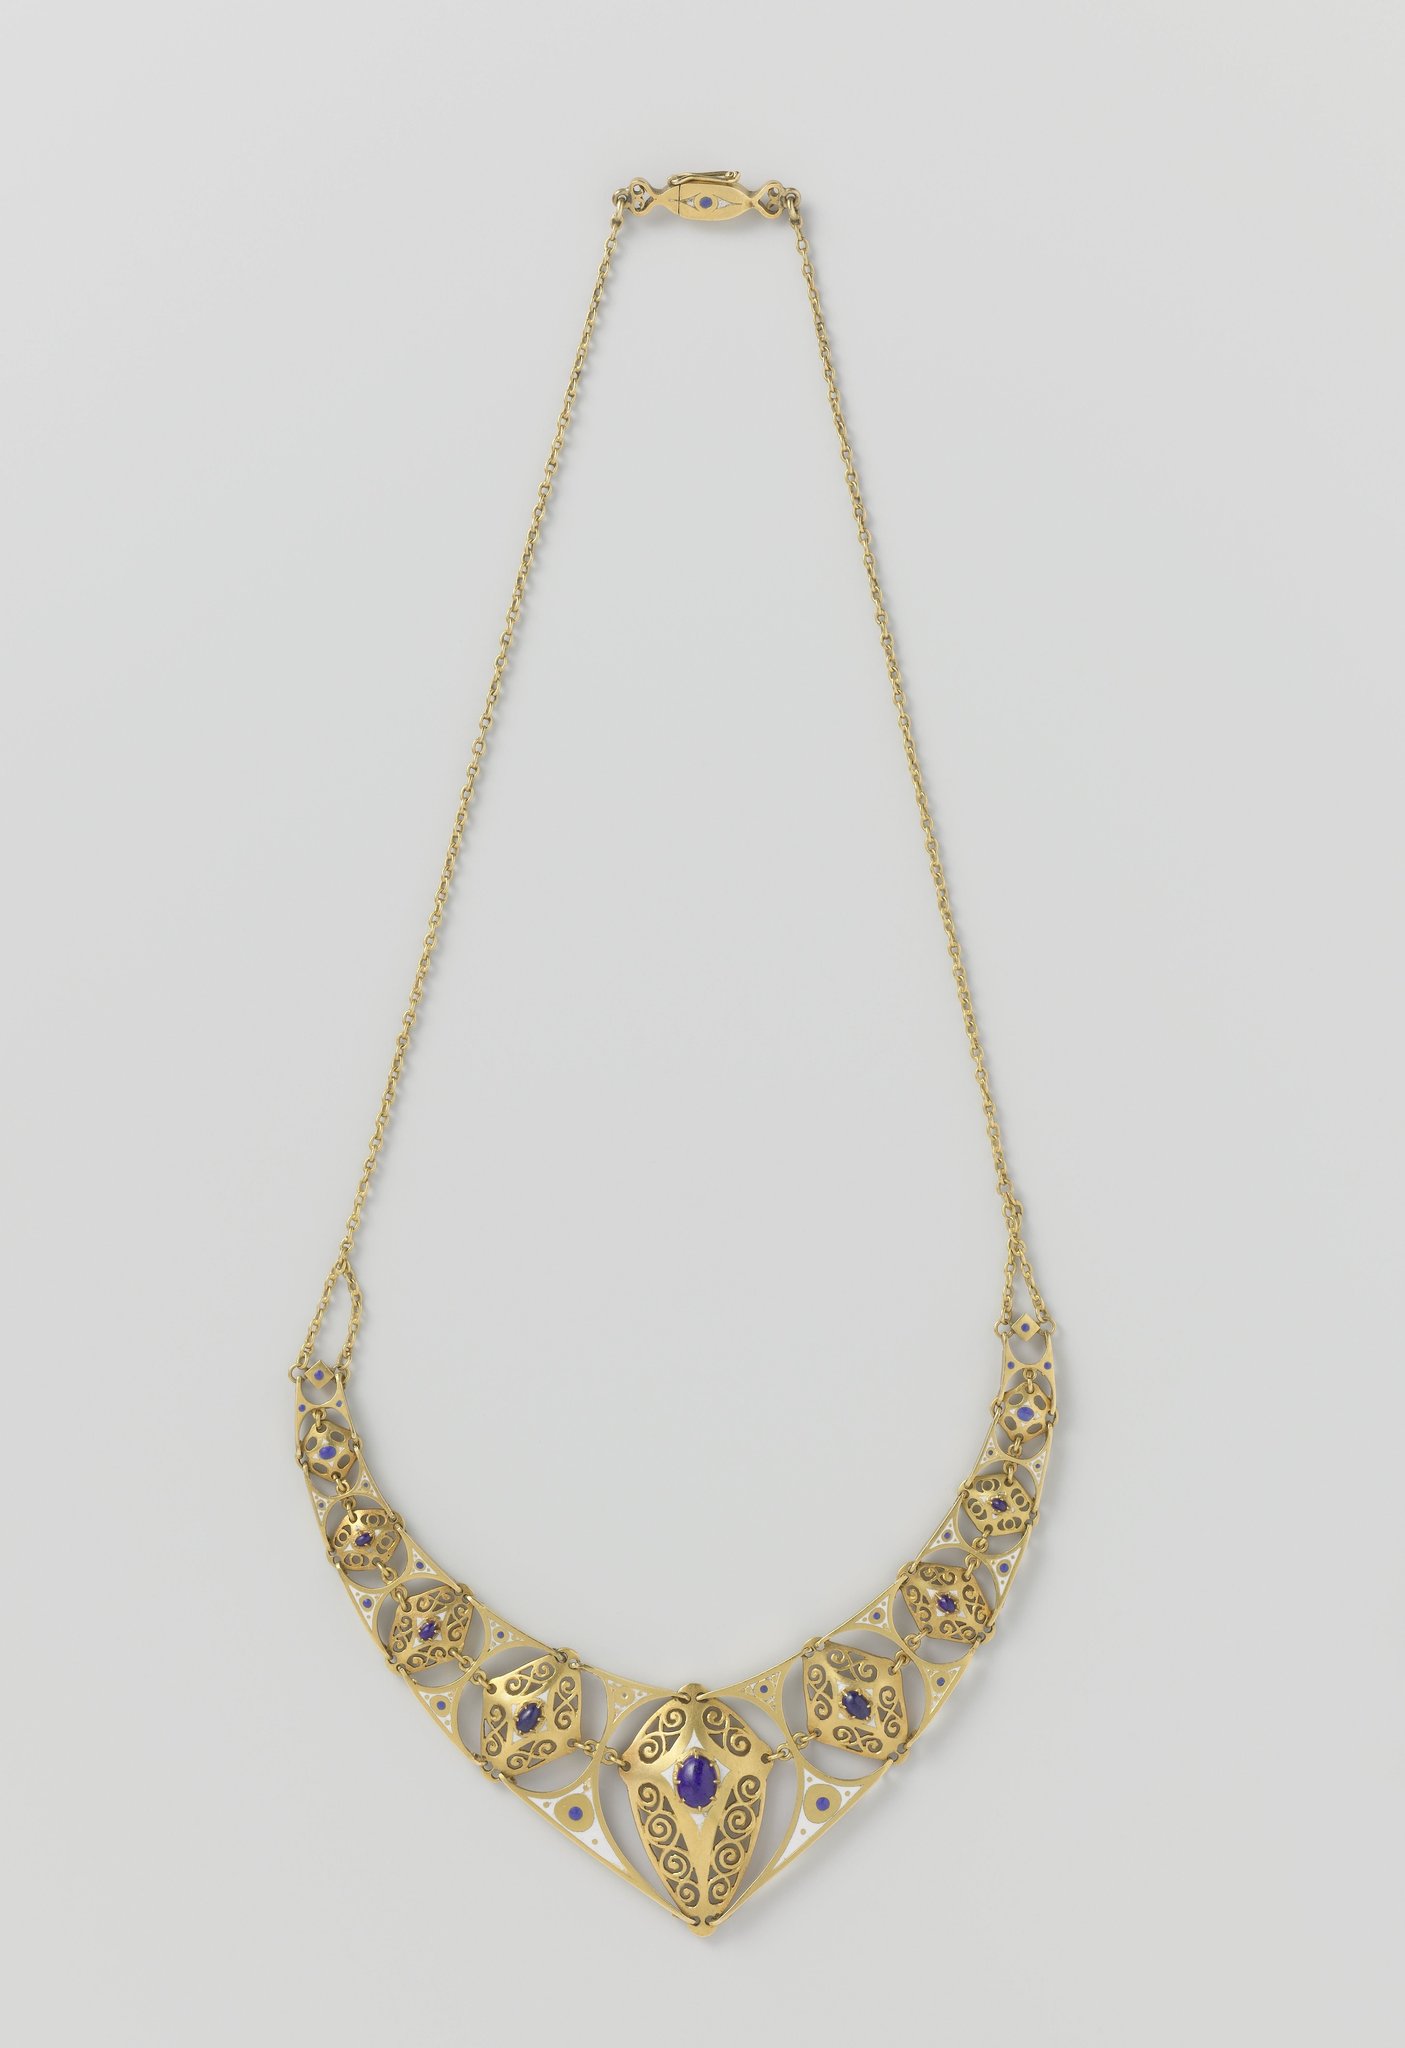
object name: necklace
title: Collier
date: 1908-1911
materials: gold, lapis lazuli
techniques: enameling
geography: amsterdam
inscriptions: alloy mark: ‘750 in bloem (Nederland, vanaf 1955)’, alloy mark: ‘gehalteteken voor aanhangsels (Nederland, vanaf 1906)’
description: Jewellery. Gold, silver, enamel and semi-precious stones. Amsterdam, c. 1908 - 1911, by L.W. van Kooten, designed by Bert Nienhuis. Given by the Prins Bernhard Fonds, 1980.